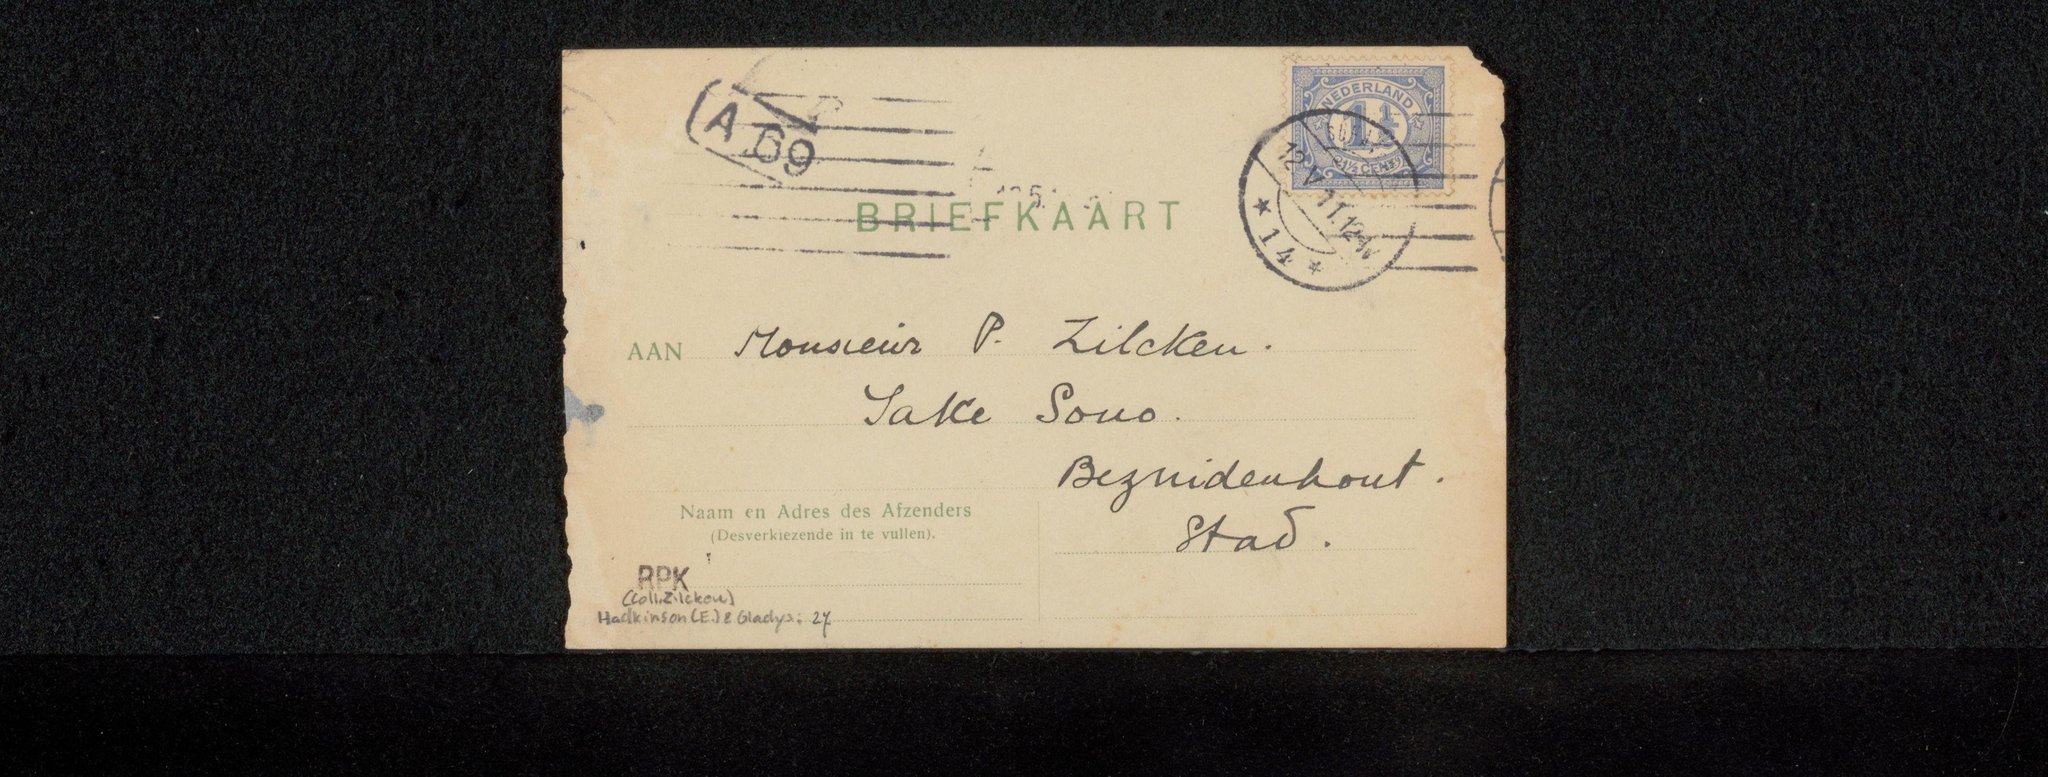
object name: postcard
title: Briefkaart aan Philip Zilcken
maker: gladys anna eleanora hadkinson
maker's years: 1895-1925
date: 1905-1911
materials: cardboard, ink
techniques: pen, writing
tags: painter, draughtsman, philip zilcken, photography, cinematography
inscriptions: collector's mark: ‘RPK’